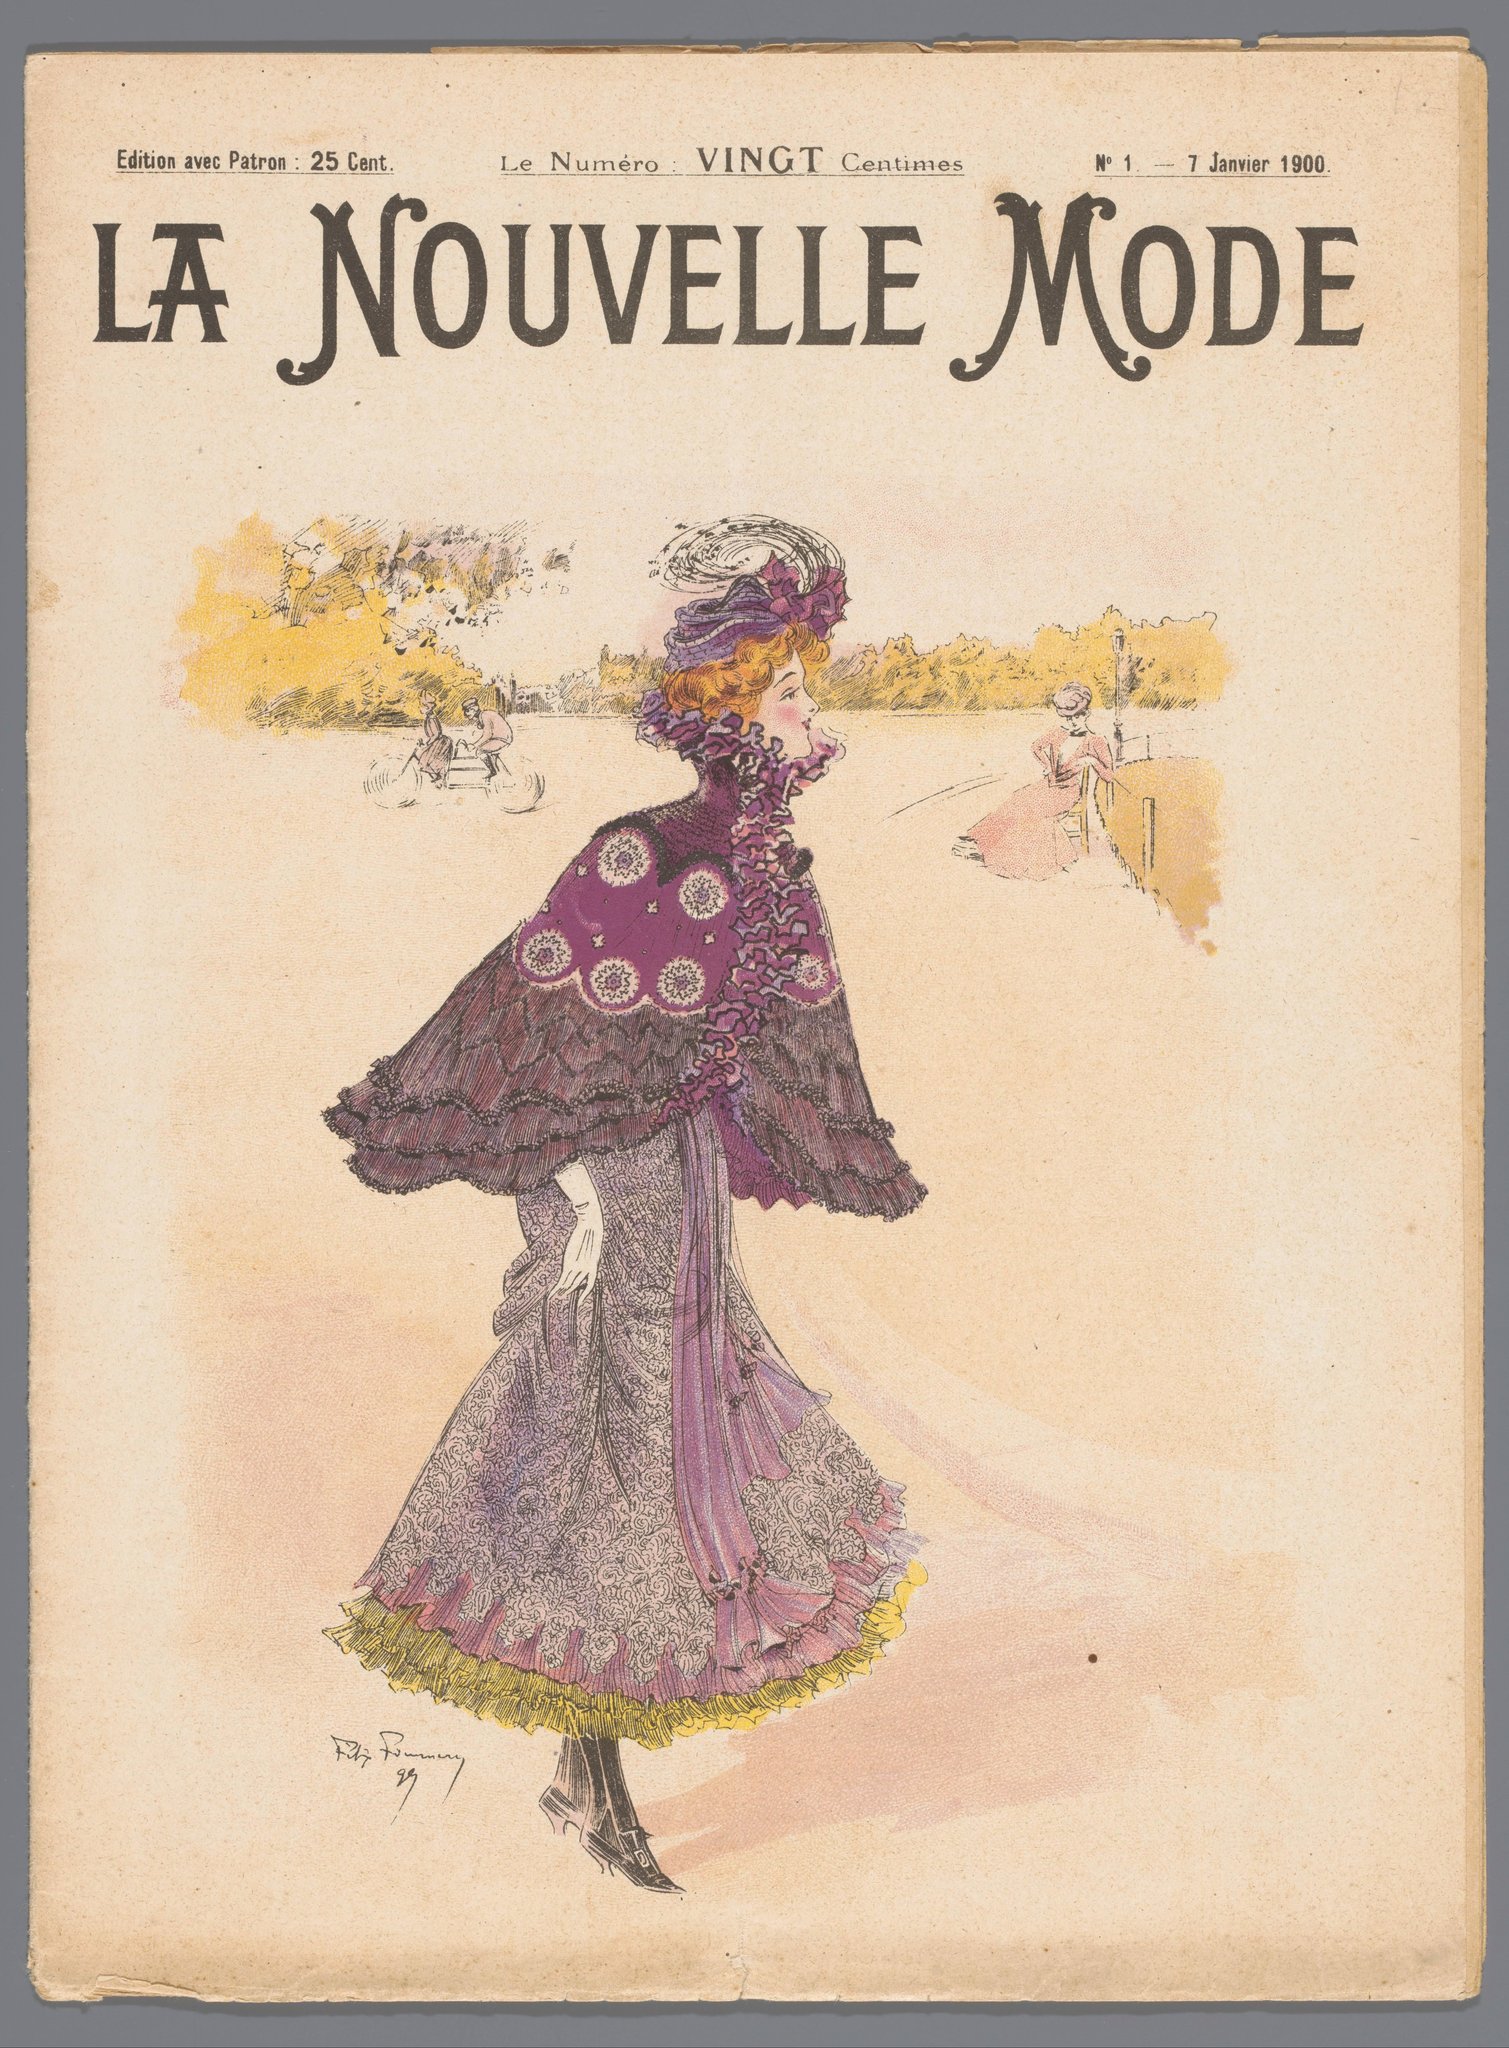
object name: fashion print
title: La Nouvelle Mode, No. 1: 1 Janvier 1900: omslag met lopende dame met pellerine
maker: Anonymous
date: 1900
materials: paper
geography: paris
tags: ensembles of pieces of clothing (two piece suit) (+ women's clothes), clothing for the upper part of the body (pelerine) (+ women's clothes), neck-gear ~ clothing (cravat) (+ women's clothes), fashion plates, head-gear: hat (+ women's clothes), dress, gown (+ women's clothes), dress, gown (+ girls' clothes)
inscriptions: title: ‘La Nouvelle Mode’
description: Omslag van La Nouvelle Mode, No. 1, 1 Januari 1900: jonge vrouw, lopend in een park, gekleed in mantel met pellerine. Hoedje met veer op het hoofd. Op de achtergrond een man en een vrouw op een tandem; rechtsachter zit een dame op een bankje.